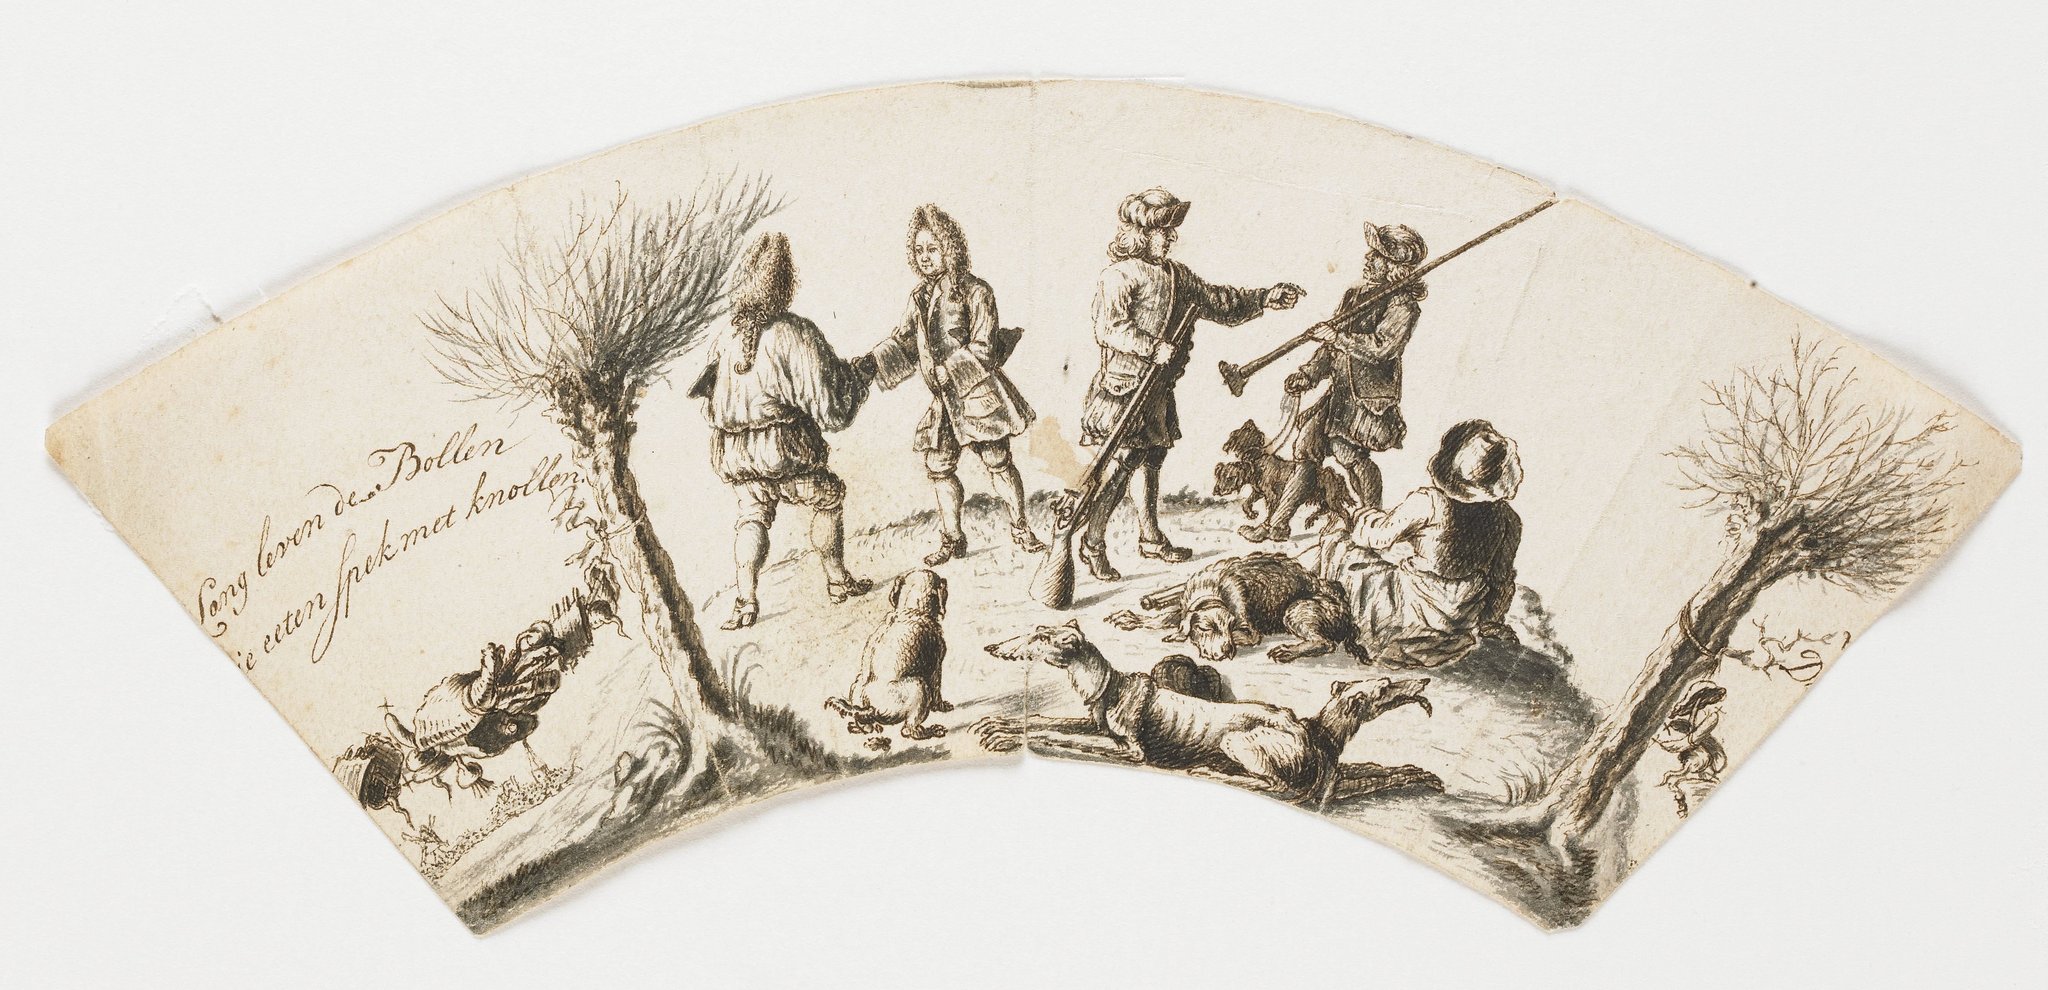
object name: wine goblet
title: Jachtgezelschap, ontwerp voor een glasgravure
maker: Anonymous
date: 1690-1725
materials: ink, paper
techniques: drawing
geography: netherlands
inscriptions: inscription: ‘lang leven de Bollen // Die eeten Spek met knollen’, watermark: ‘Vryheit’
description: Ontwerp, gewassen pentekening in bruin en grijs, voor een glasdecoratie. Op het waaiervormige blad is een jacht met jagers en honden is te zien en de tekst: LANG LEVEN DE BOLLEN/DIE EETEN SPEK MET KNOLLEN.